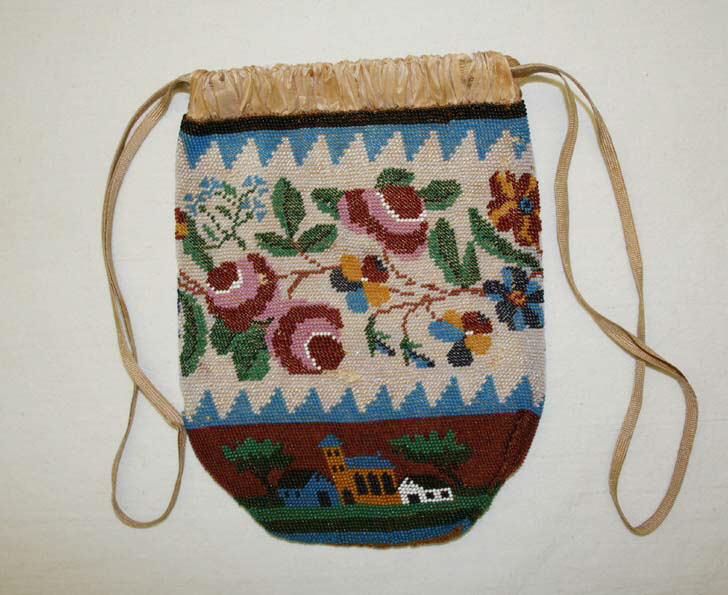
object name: drawstring bag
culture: american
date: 1785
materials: glass, silk